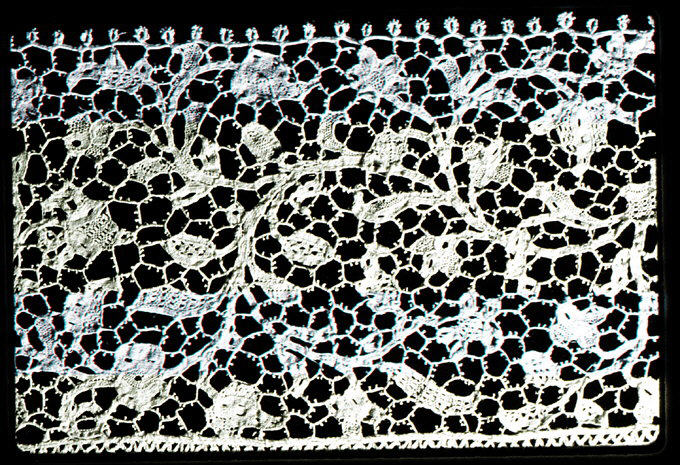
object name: edging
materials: linen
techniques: lace